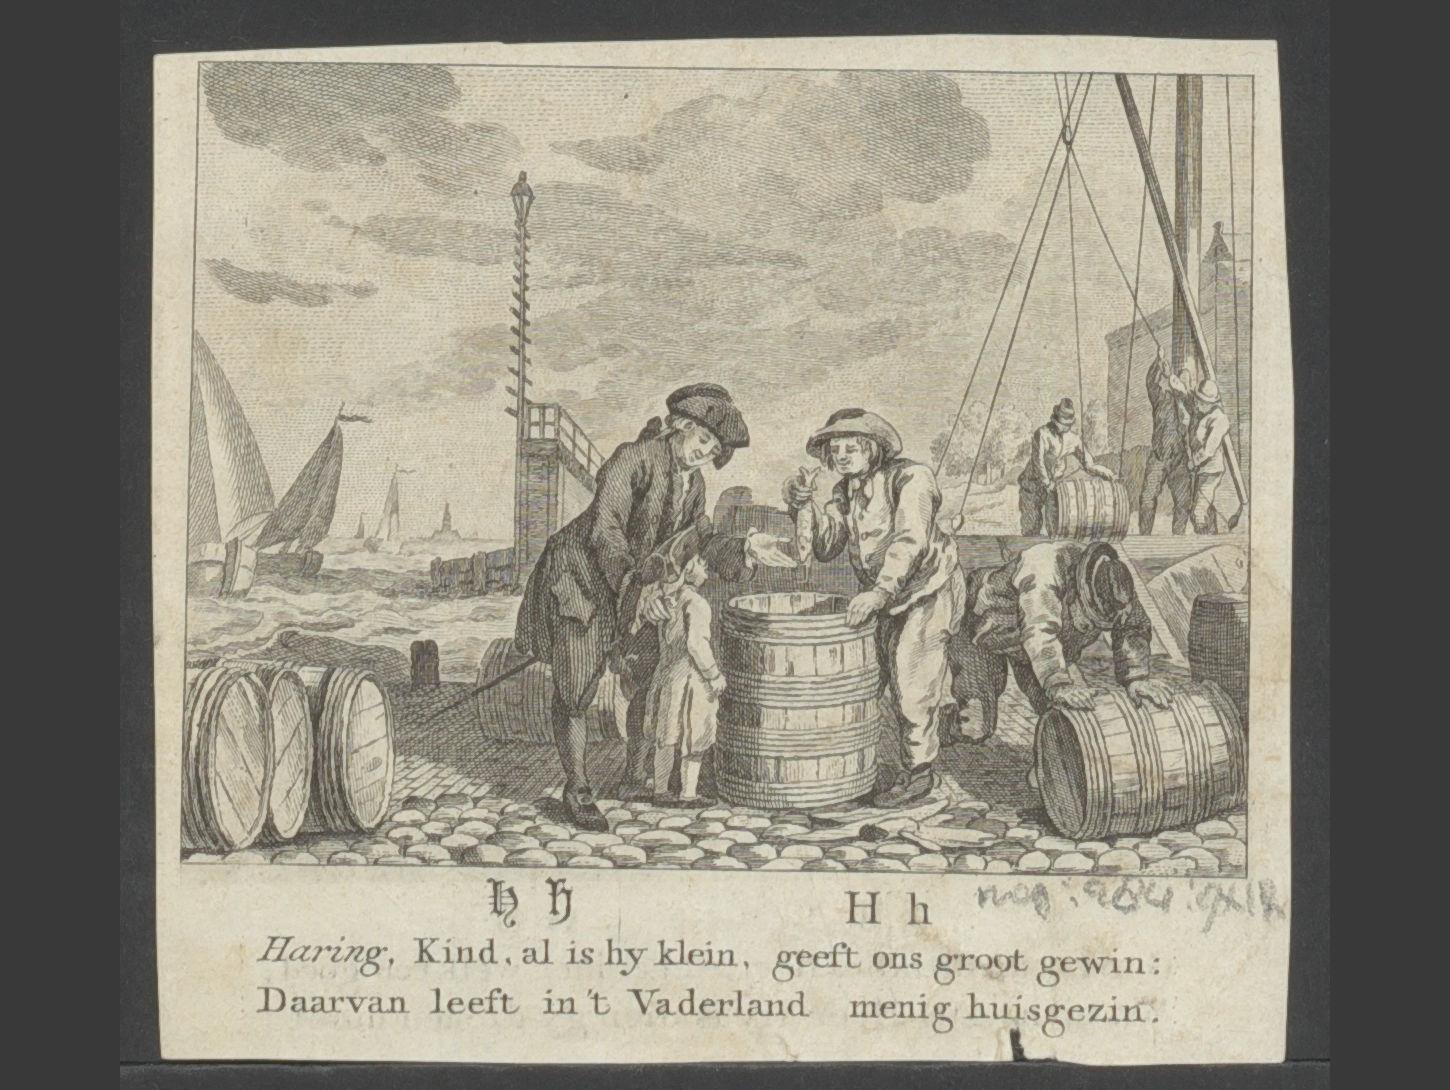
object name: book illustration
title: Haring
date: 1781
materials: paper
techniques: engraving, etching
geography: amsterdam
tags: harbour, bony fishes: herring, letters, alphabet, script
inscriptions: stamp, collector's mark: Lugt 1641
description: Vader en zoon kijken naar een man die een haring uit een ton haalt. Onder de voorstelling de letter H in twee verschillende lettertypes. Onderaan een tweeregelig vers over de haring. Onderwerpsrubrieken binnen de Atlas Zeden en Gewoonten: Onderwijs en Wetenschappen, Opvoeding en Onderwijs, Haneboeken en schoolprenten.